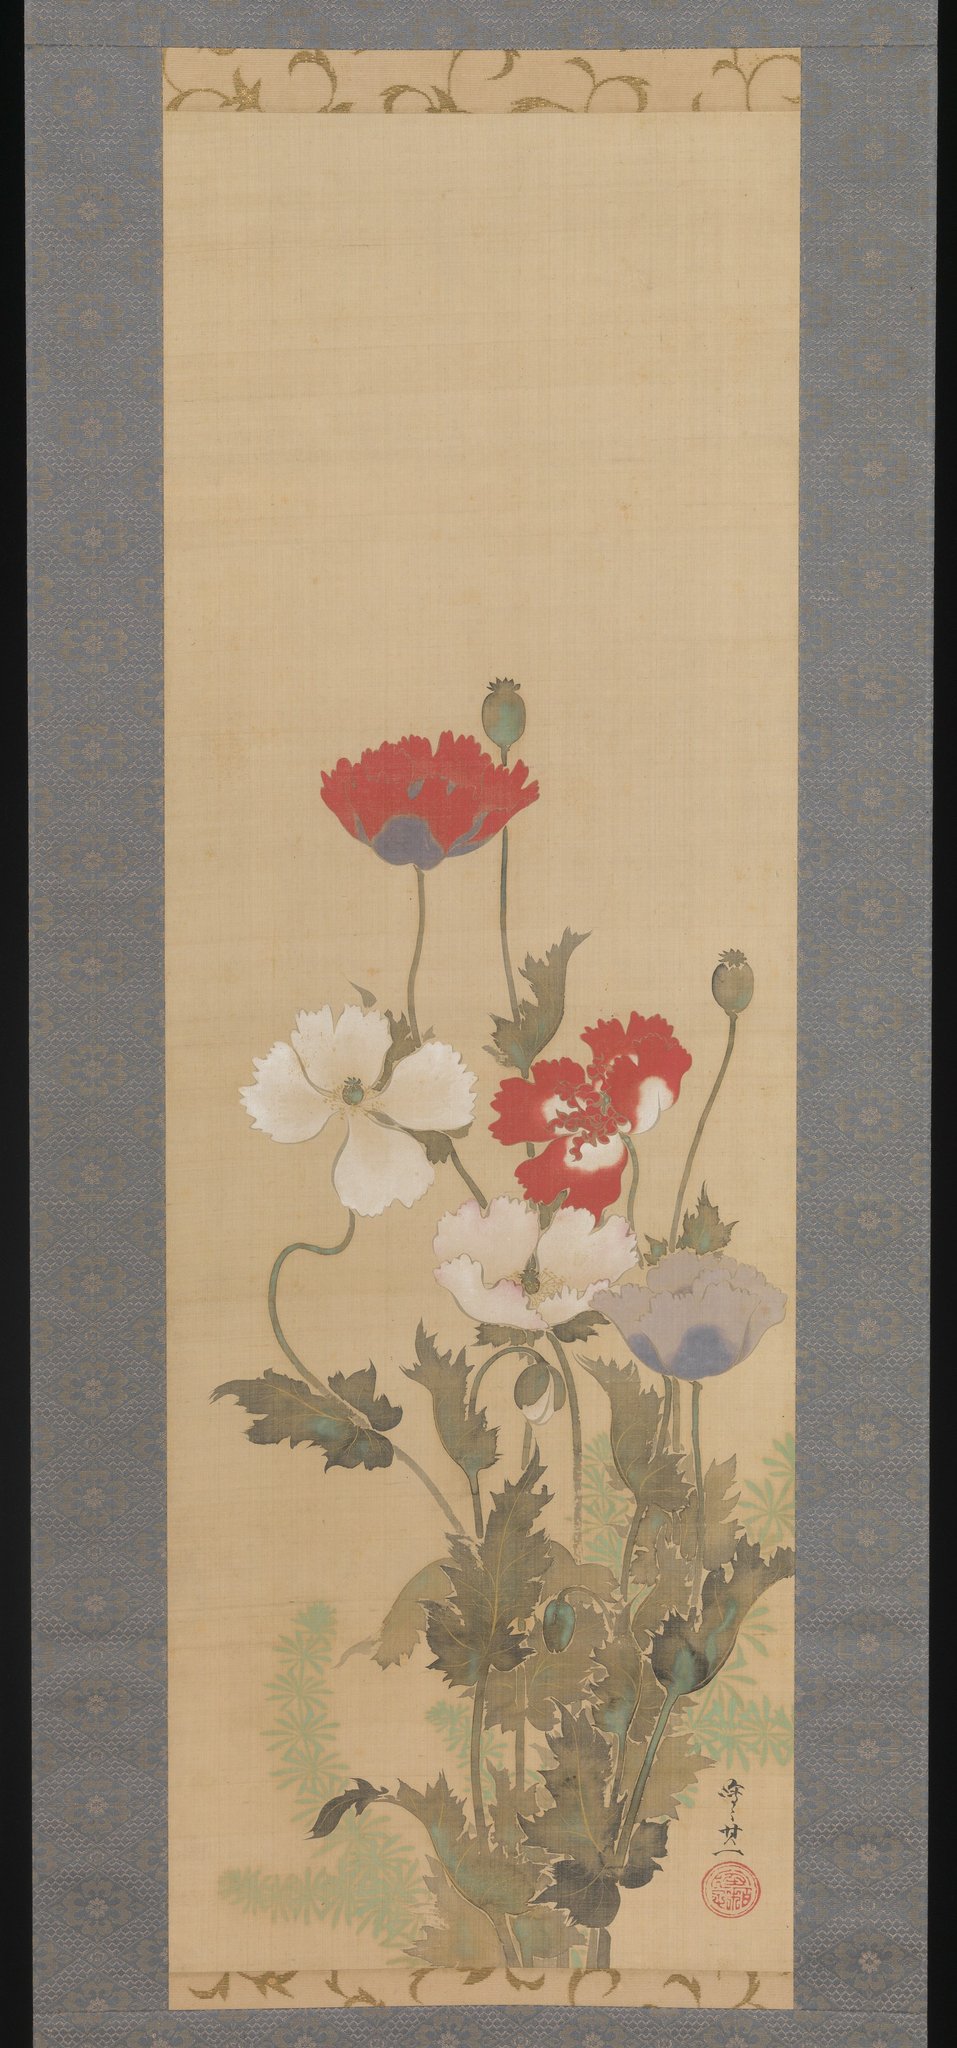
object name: hanging scroll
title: Poppies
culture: japanese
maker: suzuki kiitsu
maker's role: artist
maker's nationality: japanese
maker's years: 1796-1858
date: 1834-1866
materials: ink, silk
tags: poppies